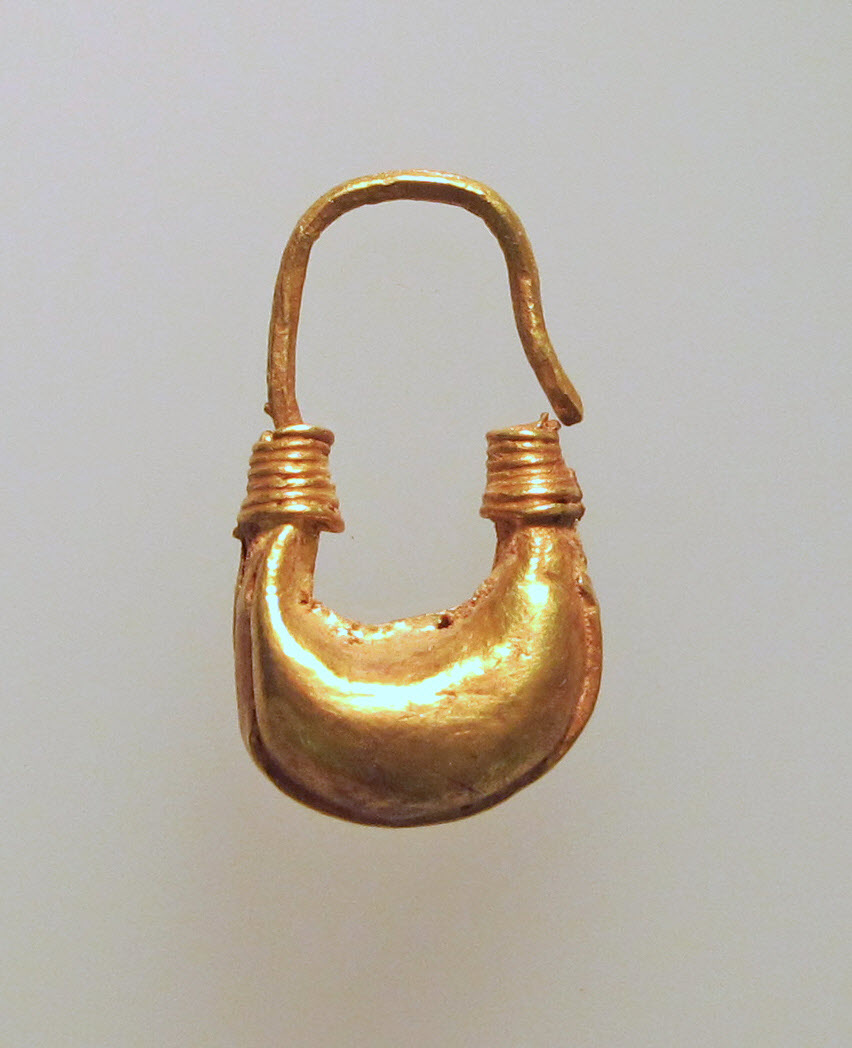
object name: earring, boat shaped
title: Earring, boat-shaped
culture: cypriot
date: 3900 BCE-100 CE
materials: gold